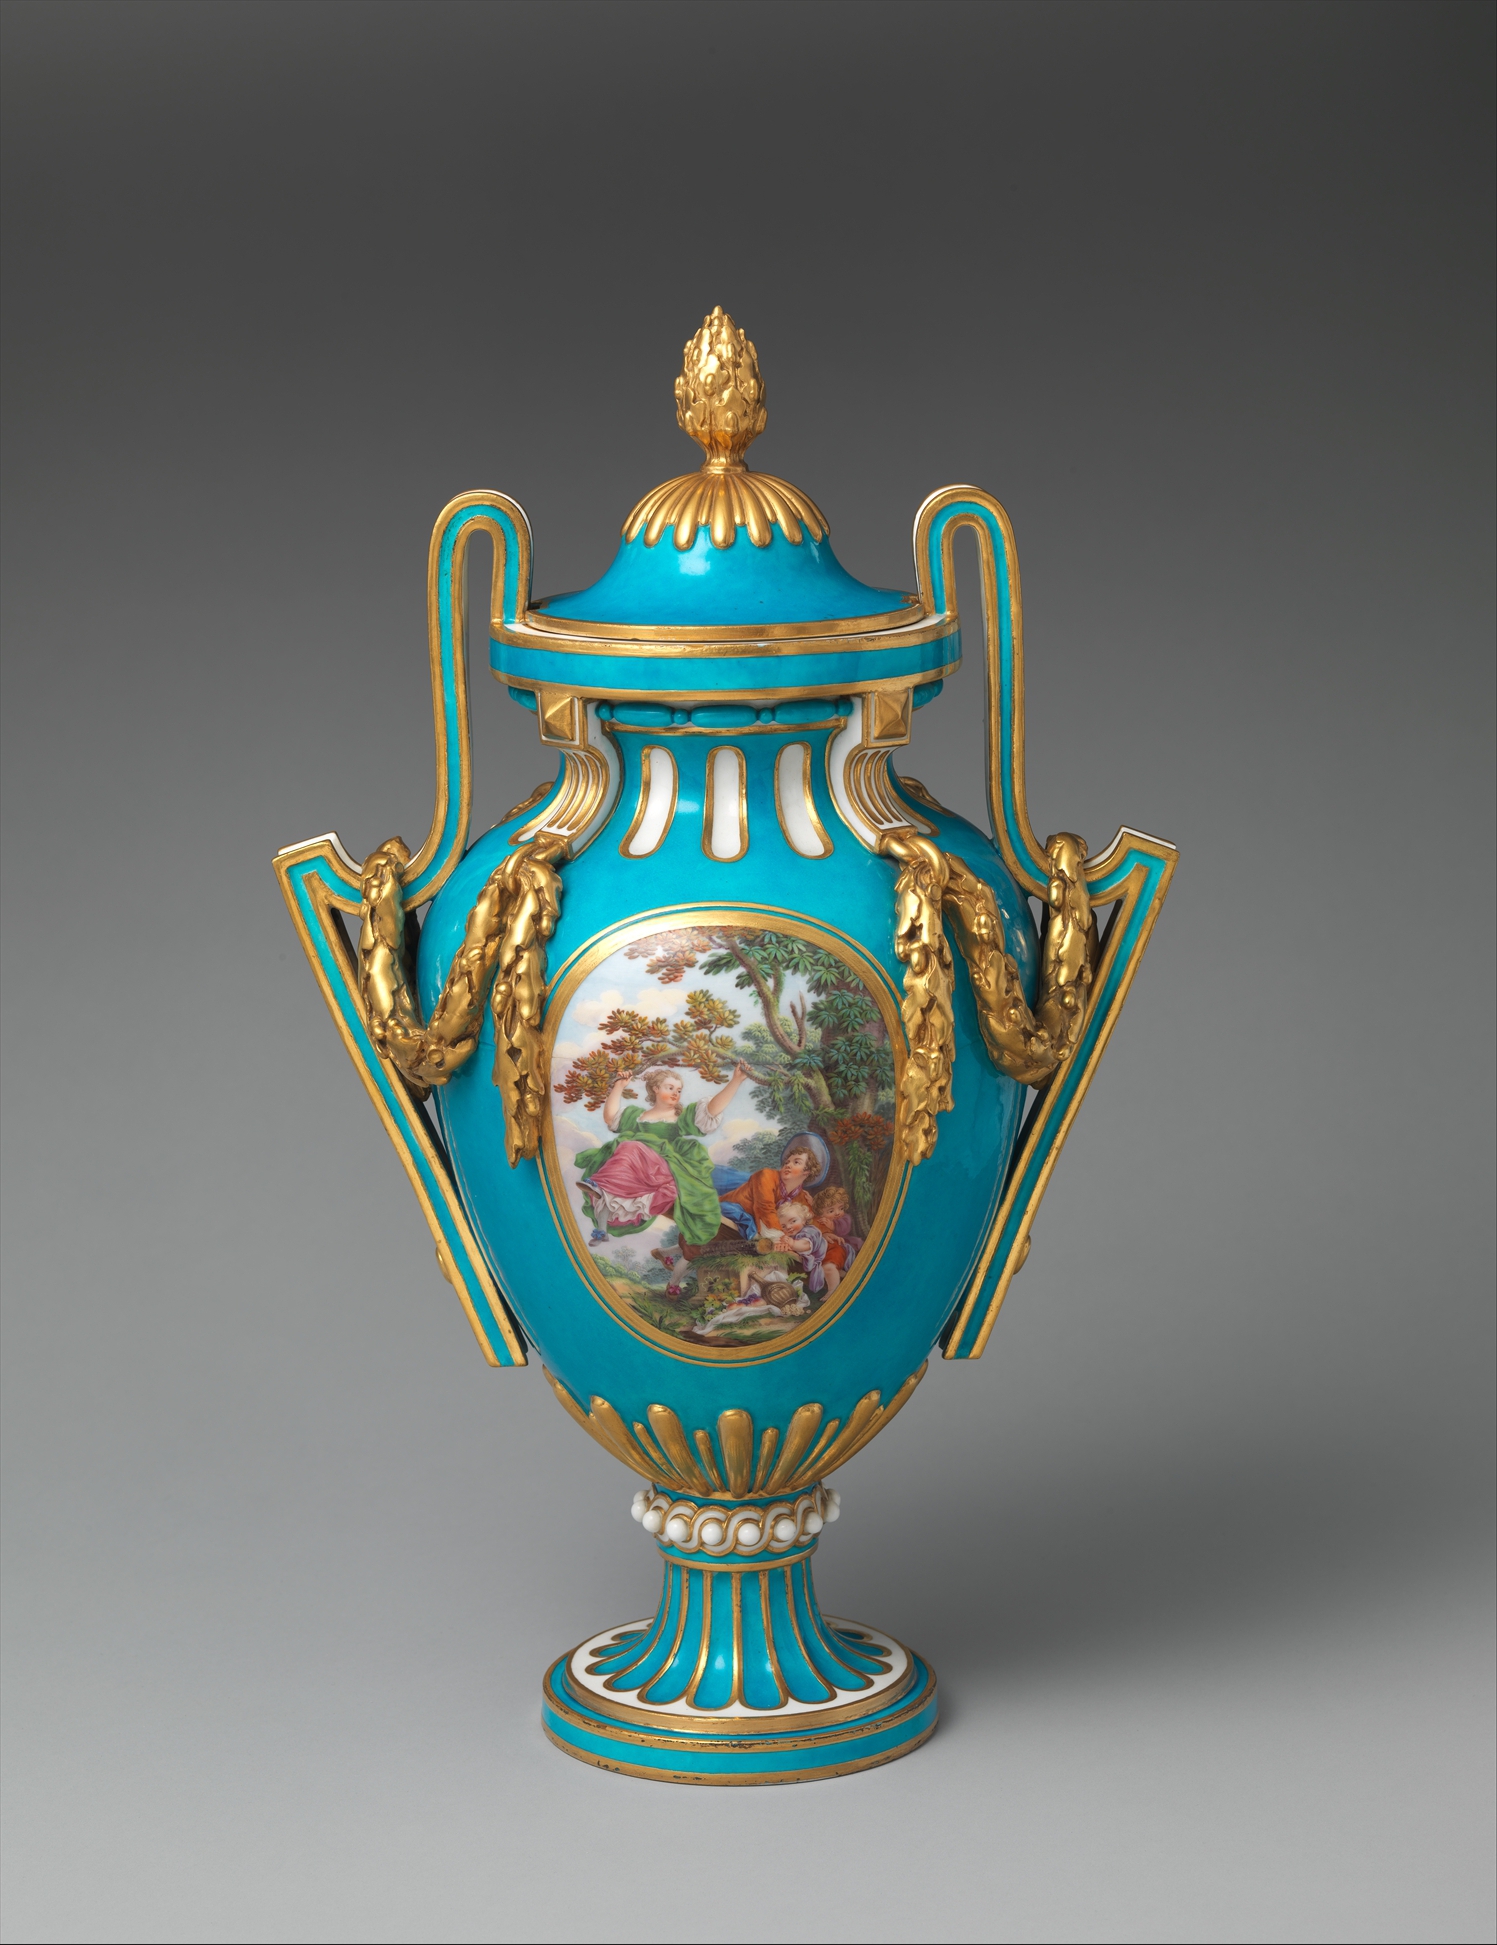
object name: vase with cover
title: Vase with cover (probably vase à bâtons rompus)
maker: sèvres manufactory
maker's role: manufactory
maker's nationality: french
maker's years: 1740-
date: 1771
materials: soft paste porcelain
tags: children,men,women